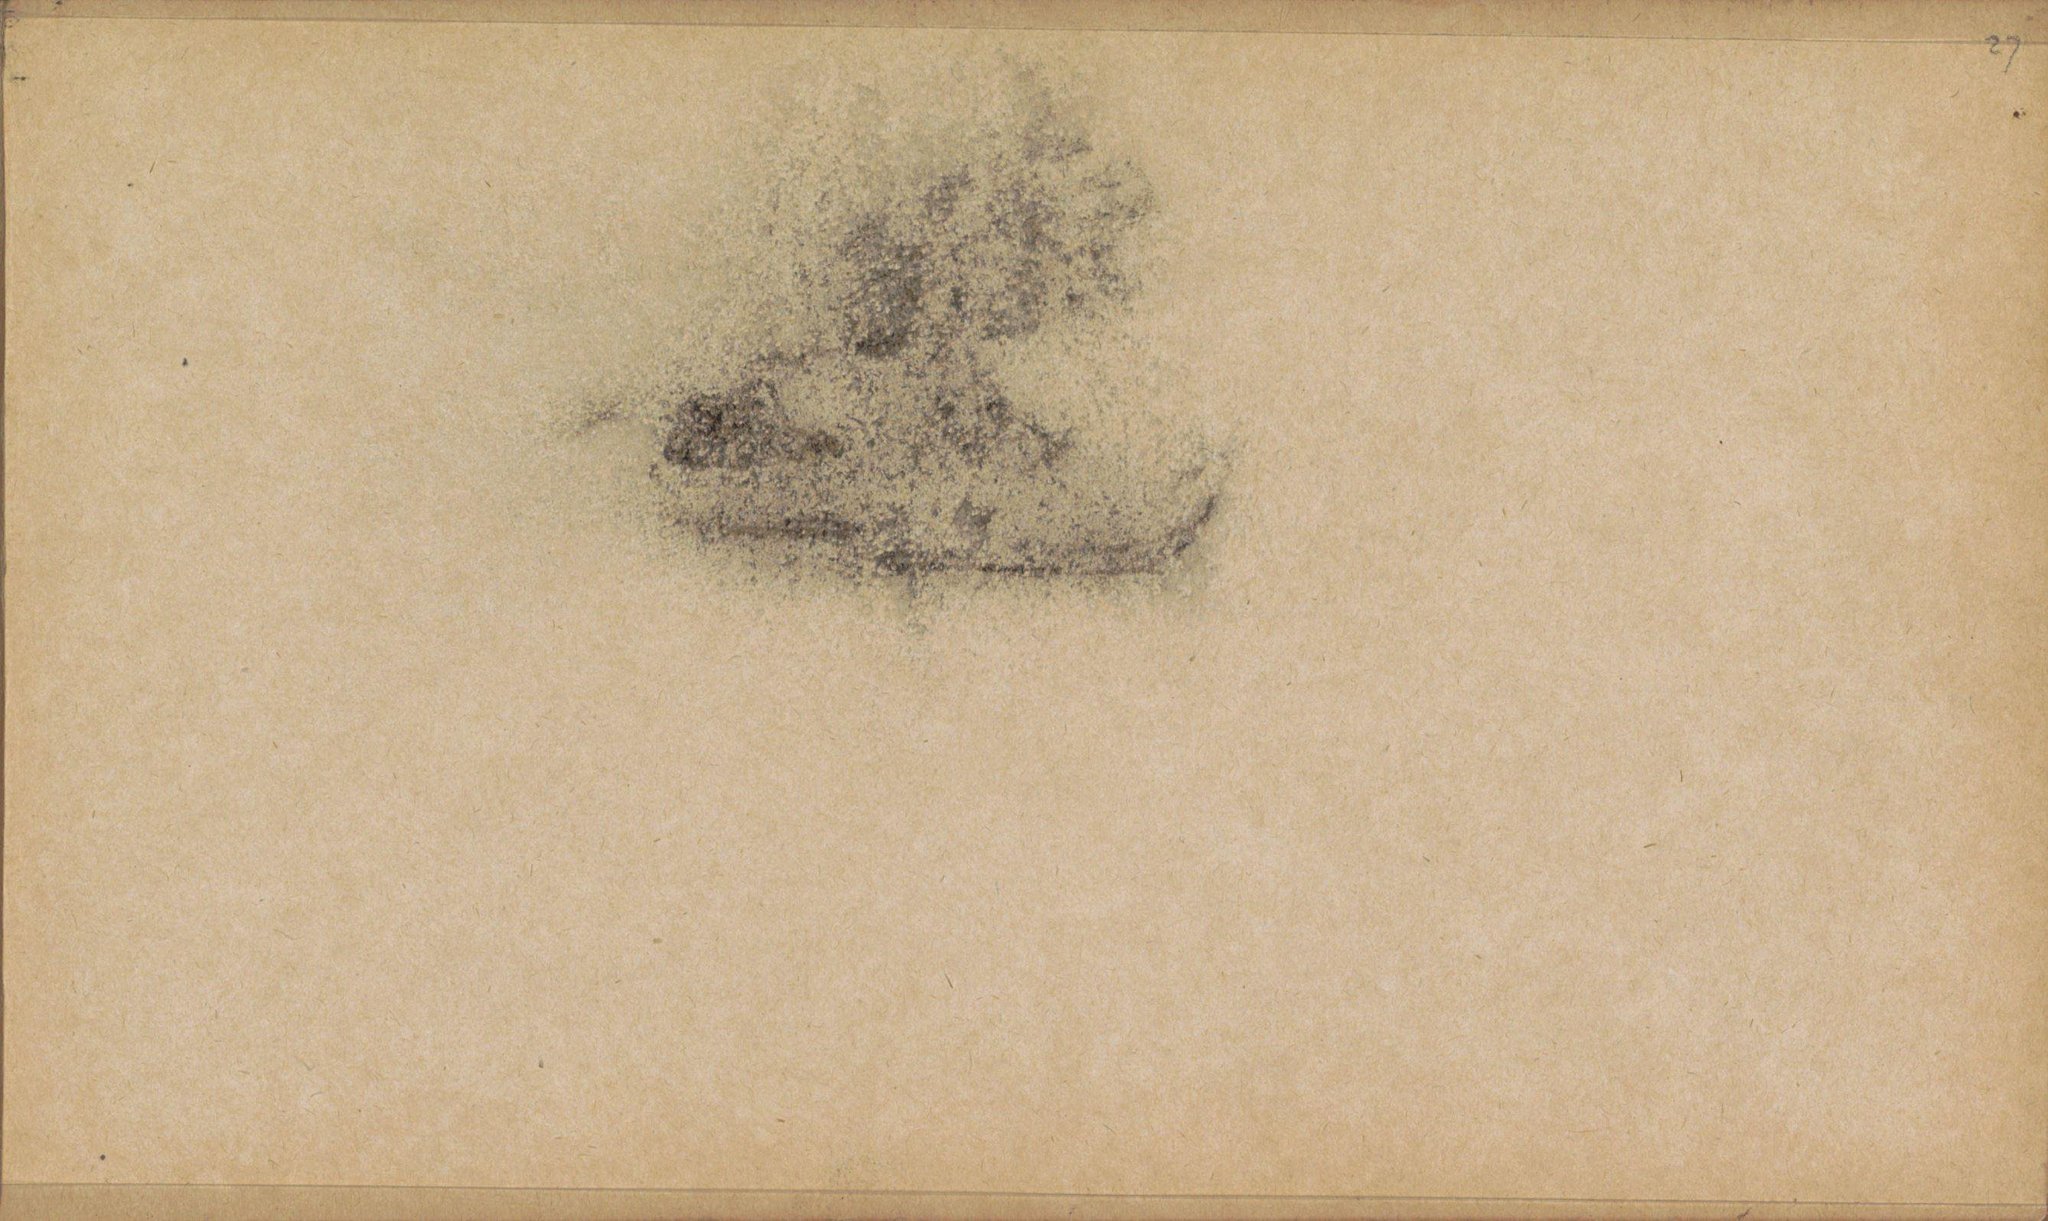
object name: sketchbook leaf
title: Abklatsch van een krijttekening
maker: willem witsen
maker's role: draughtsman, painter, print maker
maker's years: 1860-1923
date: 1888-1897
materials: paper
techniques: printmaking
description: Pagina 27 uit een schetsboek met 25 bladen.